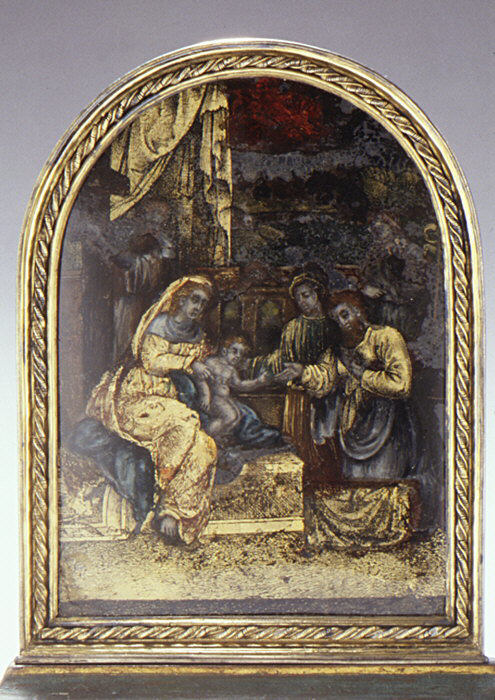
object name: pax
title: Adoration of the Magi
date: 1501-1600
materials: gilt copper, quartz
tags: madonna and child,adoration of the magi